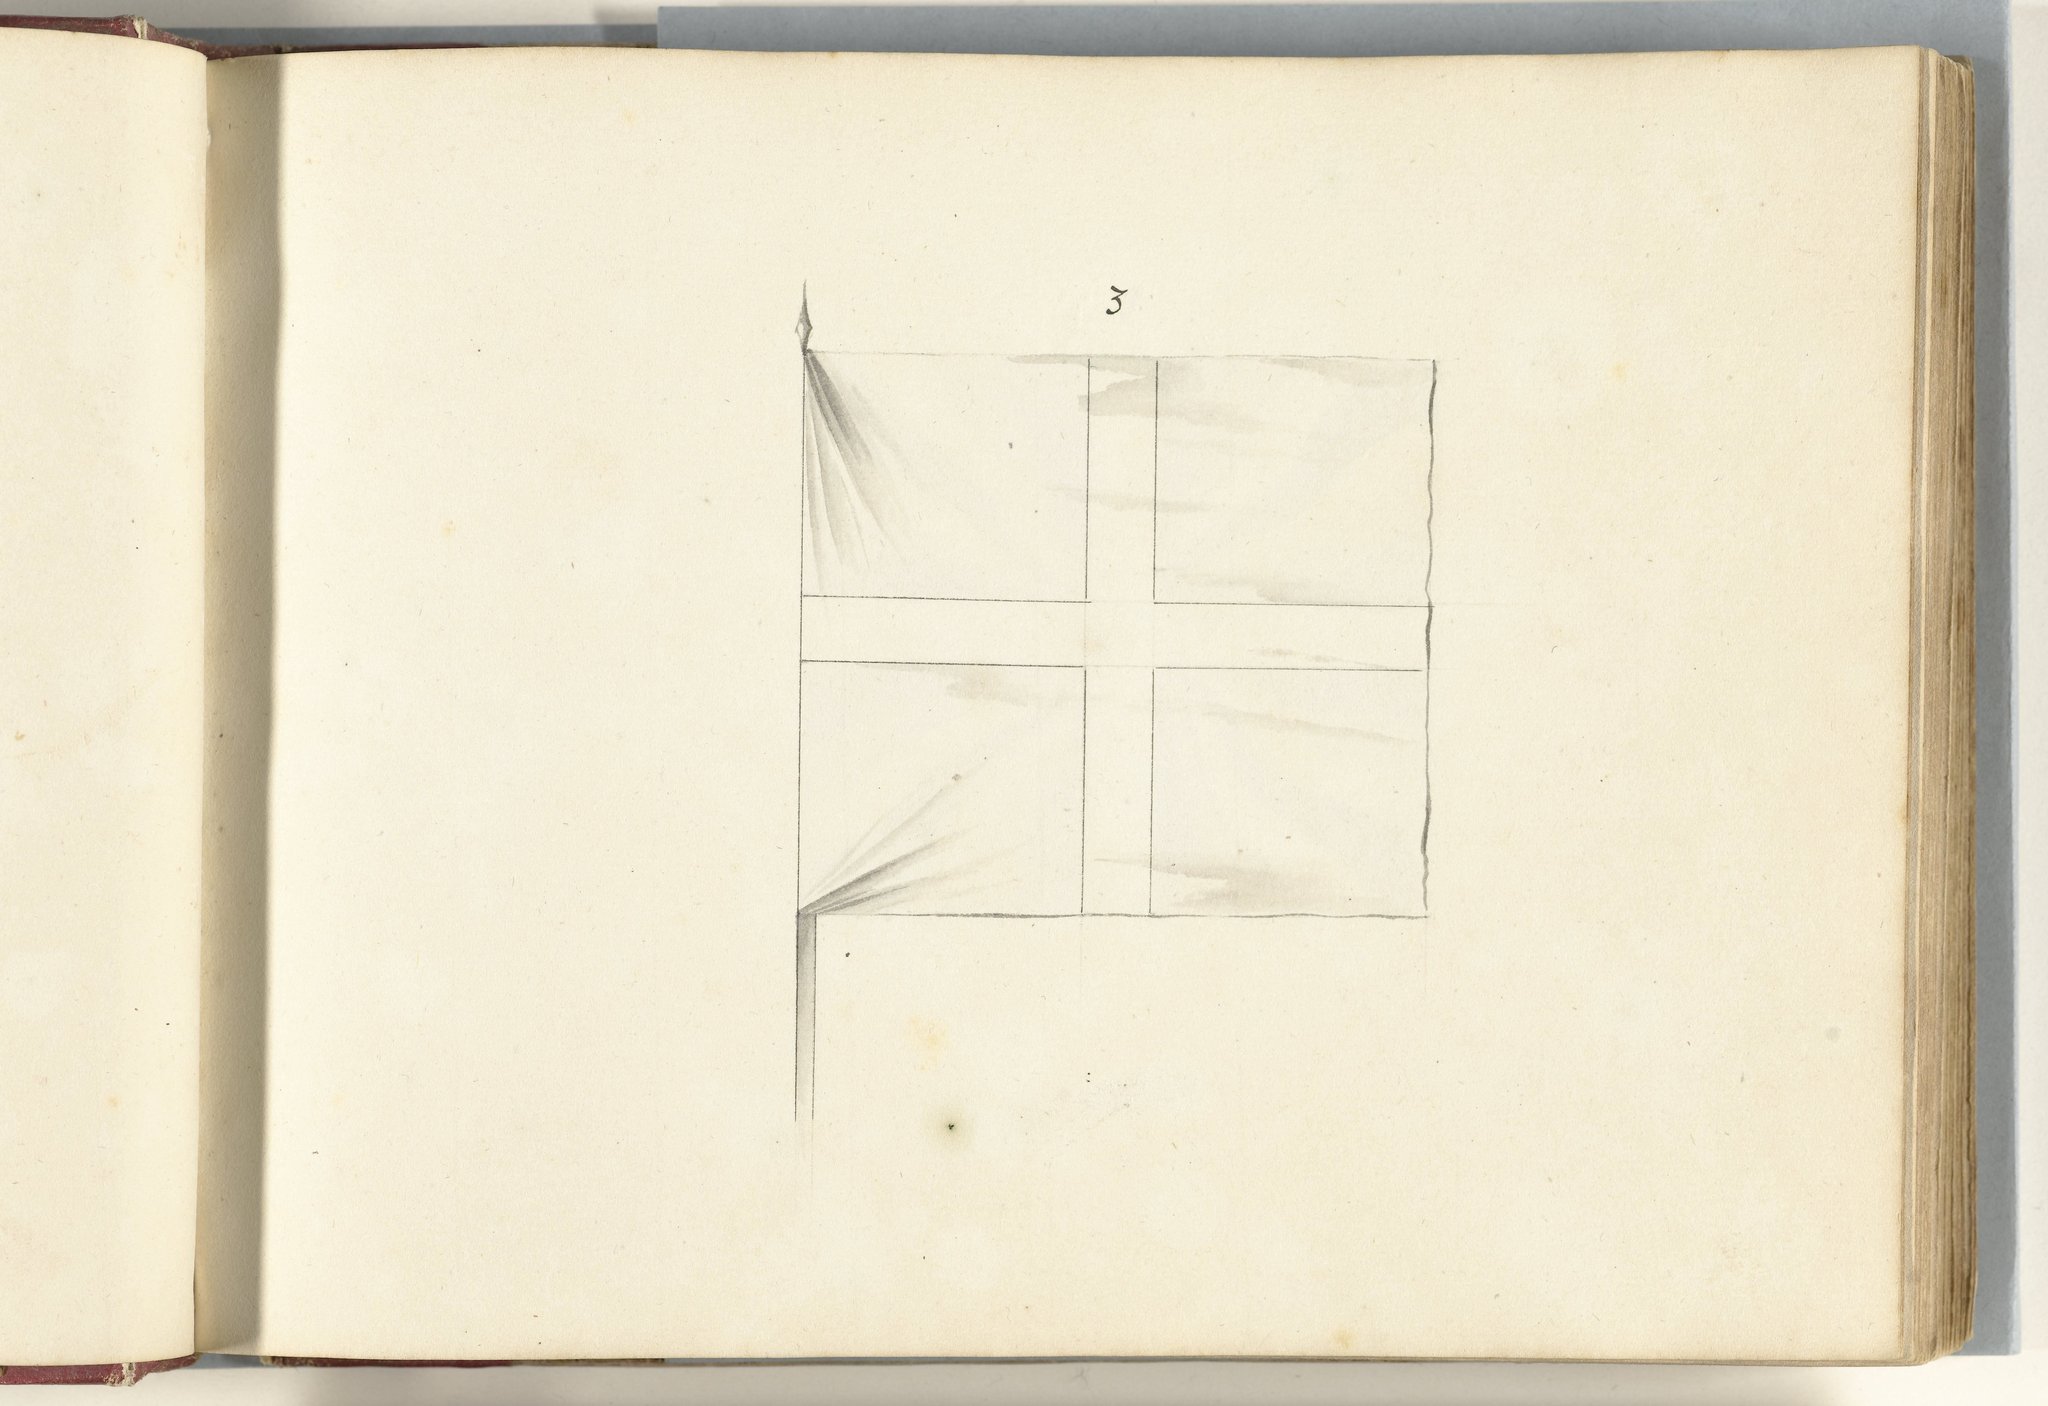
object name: drawing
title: Frans vaandel veroverd bij Oostende, 1706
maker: Anonymous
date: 1713-1720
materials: paper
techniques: drawing, writing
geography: northern netherlands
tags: (military) flags and standards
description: Frans vaandel veroverd bij Oostende, 1706. In het boek met tekeningen van Franse vaandels, standaarden en pauken, veroverd tijdens de Spaanse Successieoorlog (1701-1713).